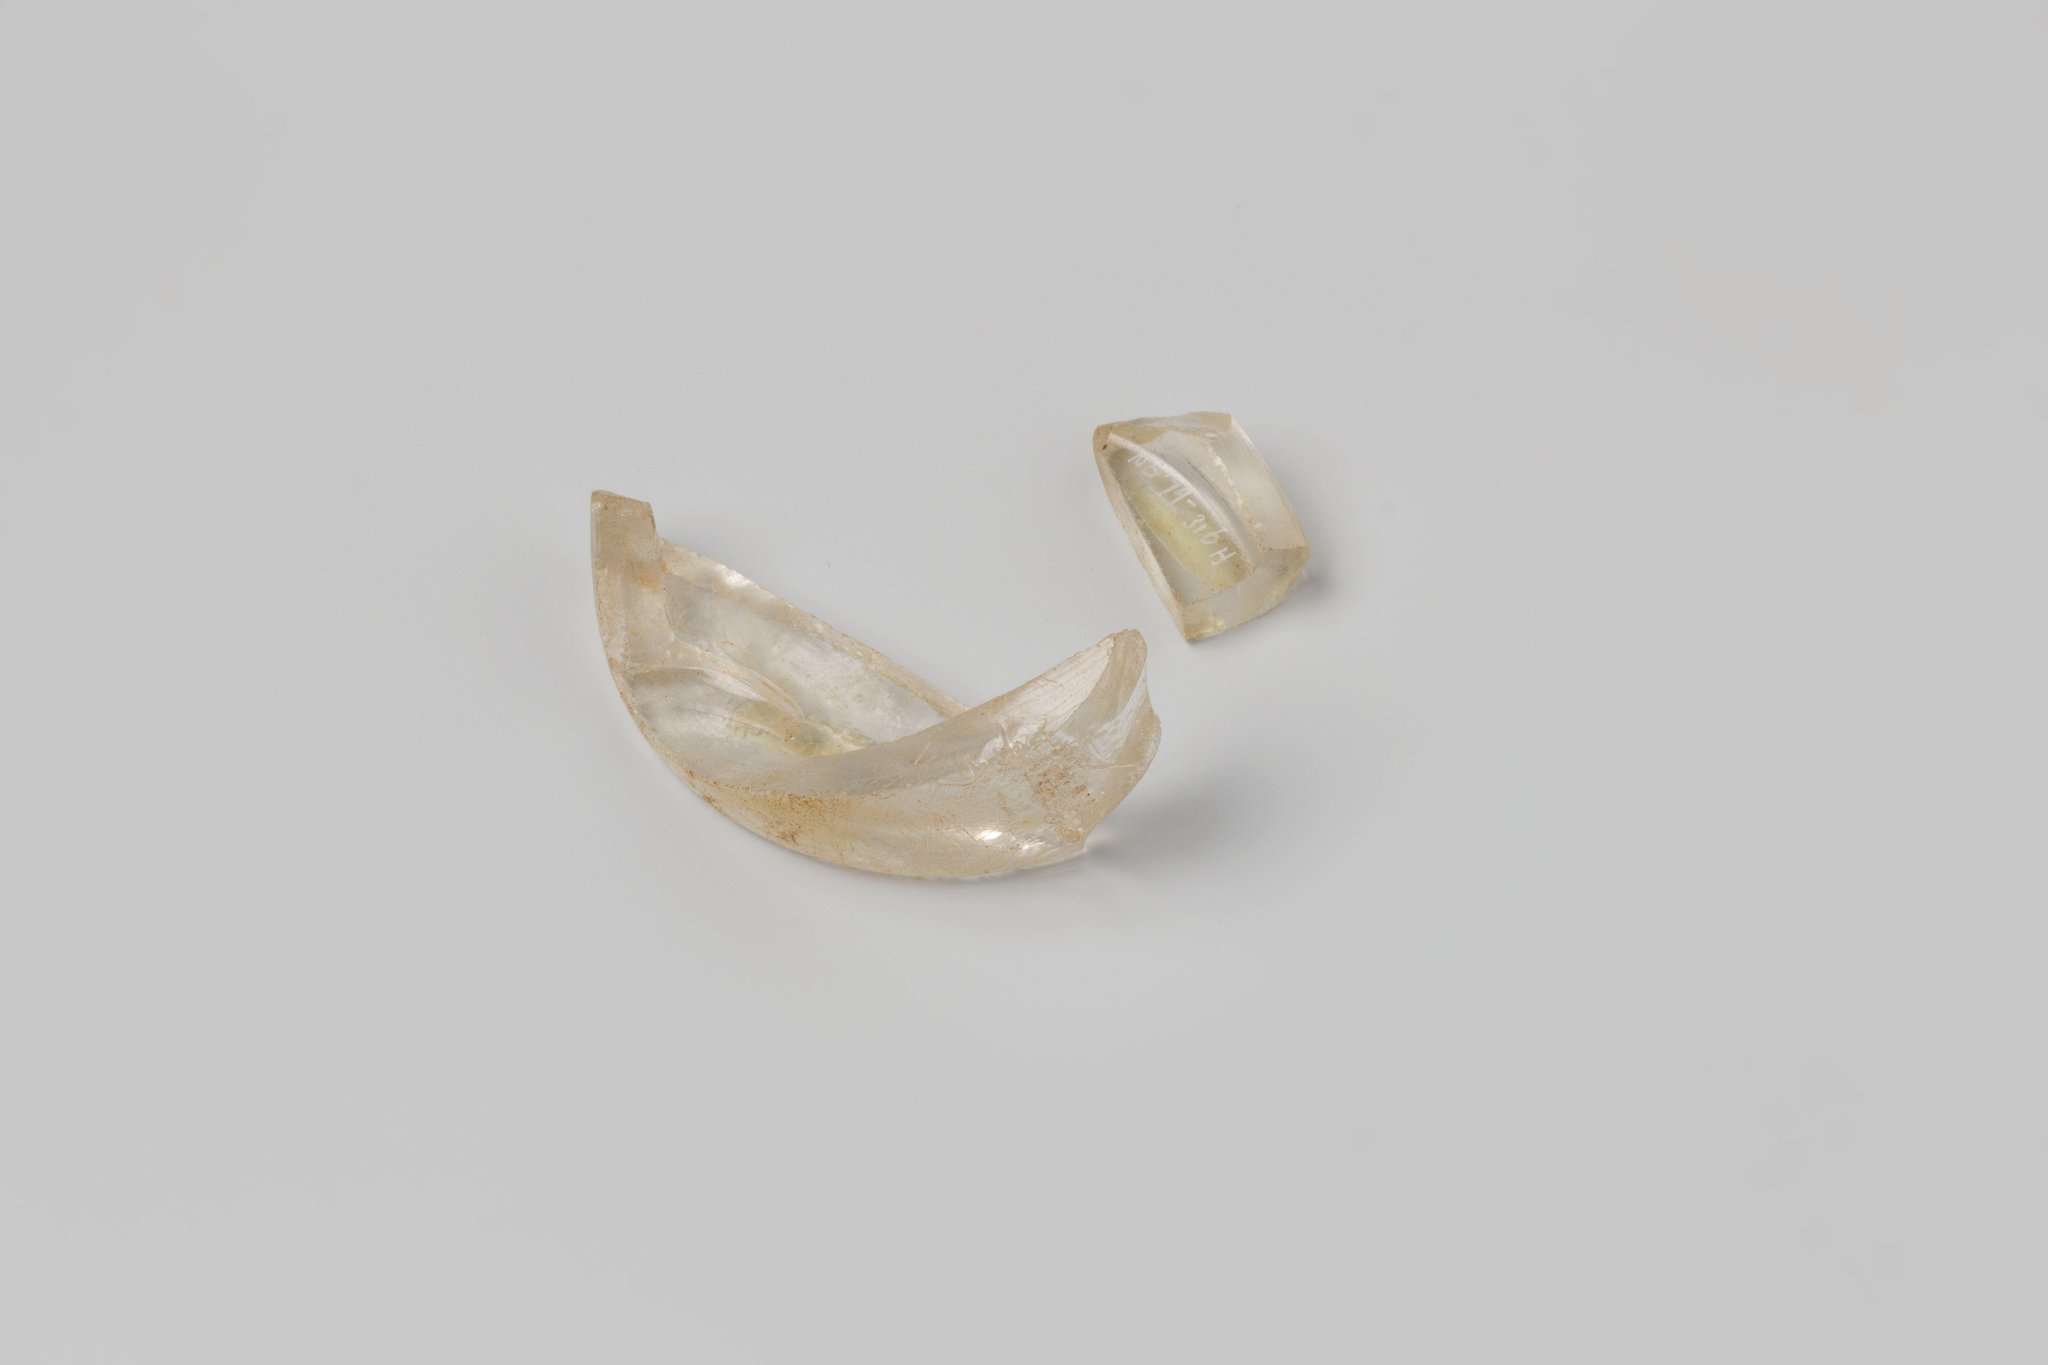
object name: drinking glass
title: Fragment tuimelaar uit het wrak van de Oost-Indiëvaarder Hollandia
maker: Anonymous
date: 1700-1743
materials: glass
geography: netherlands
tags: verenigde oostindische compagnie, hollandia (schip), annet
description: Base, fragm, circular, flat, straight sides. Tumbler.